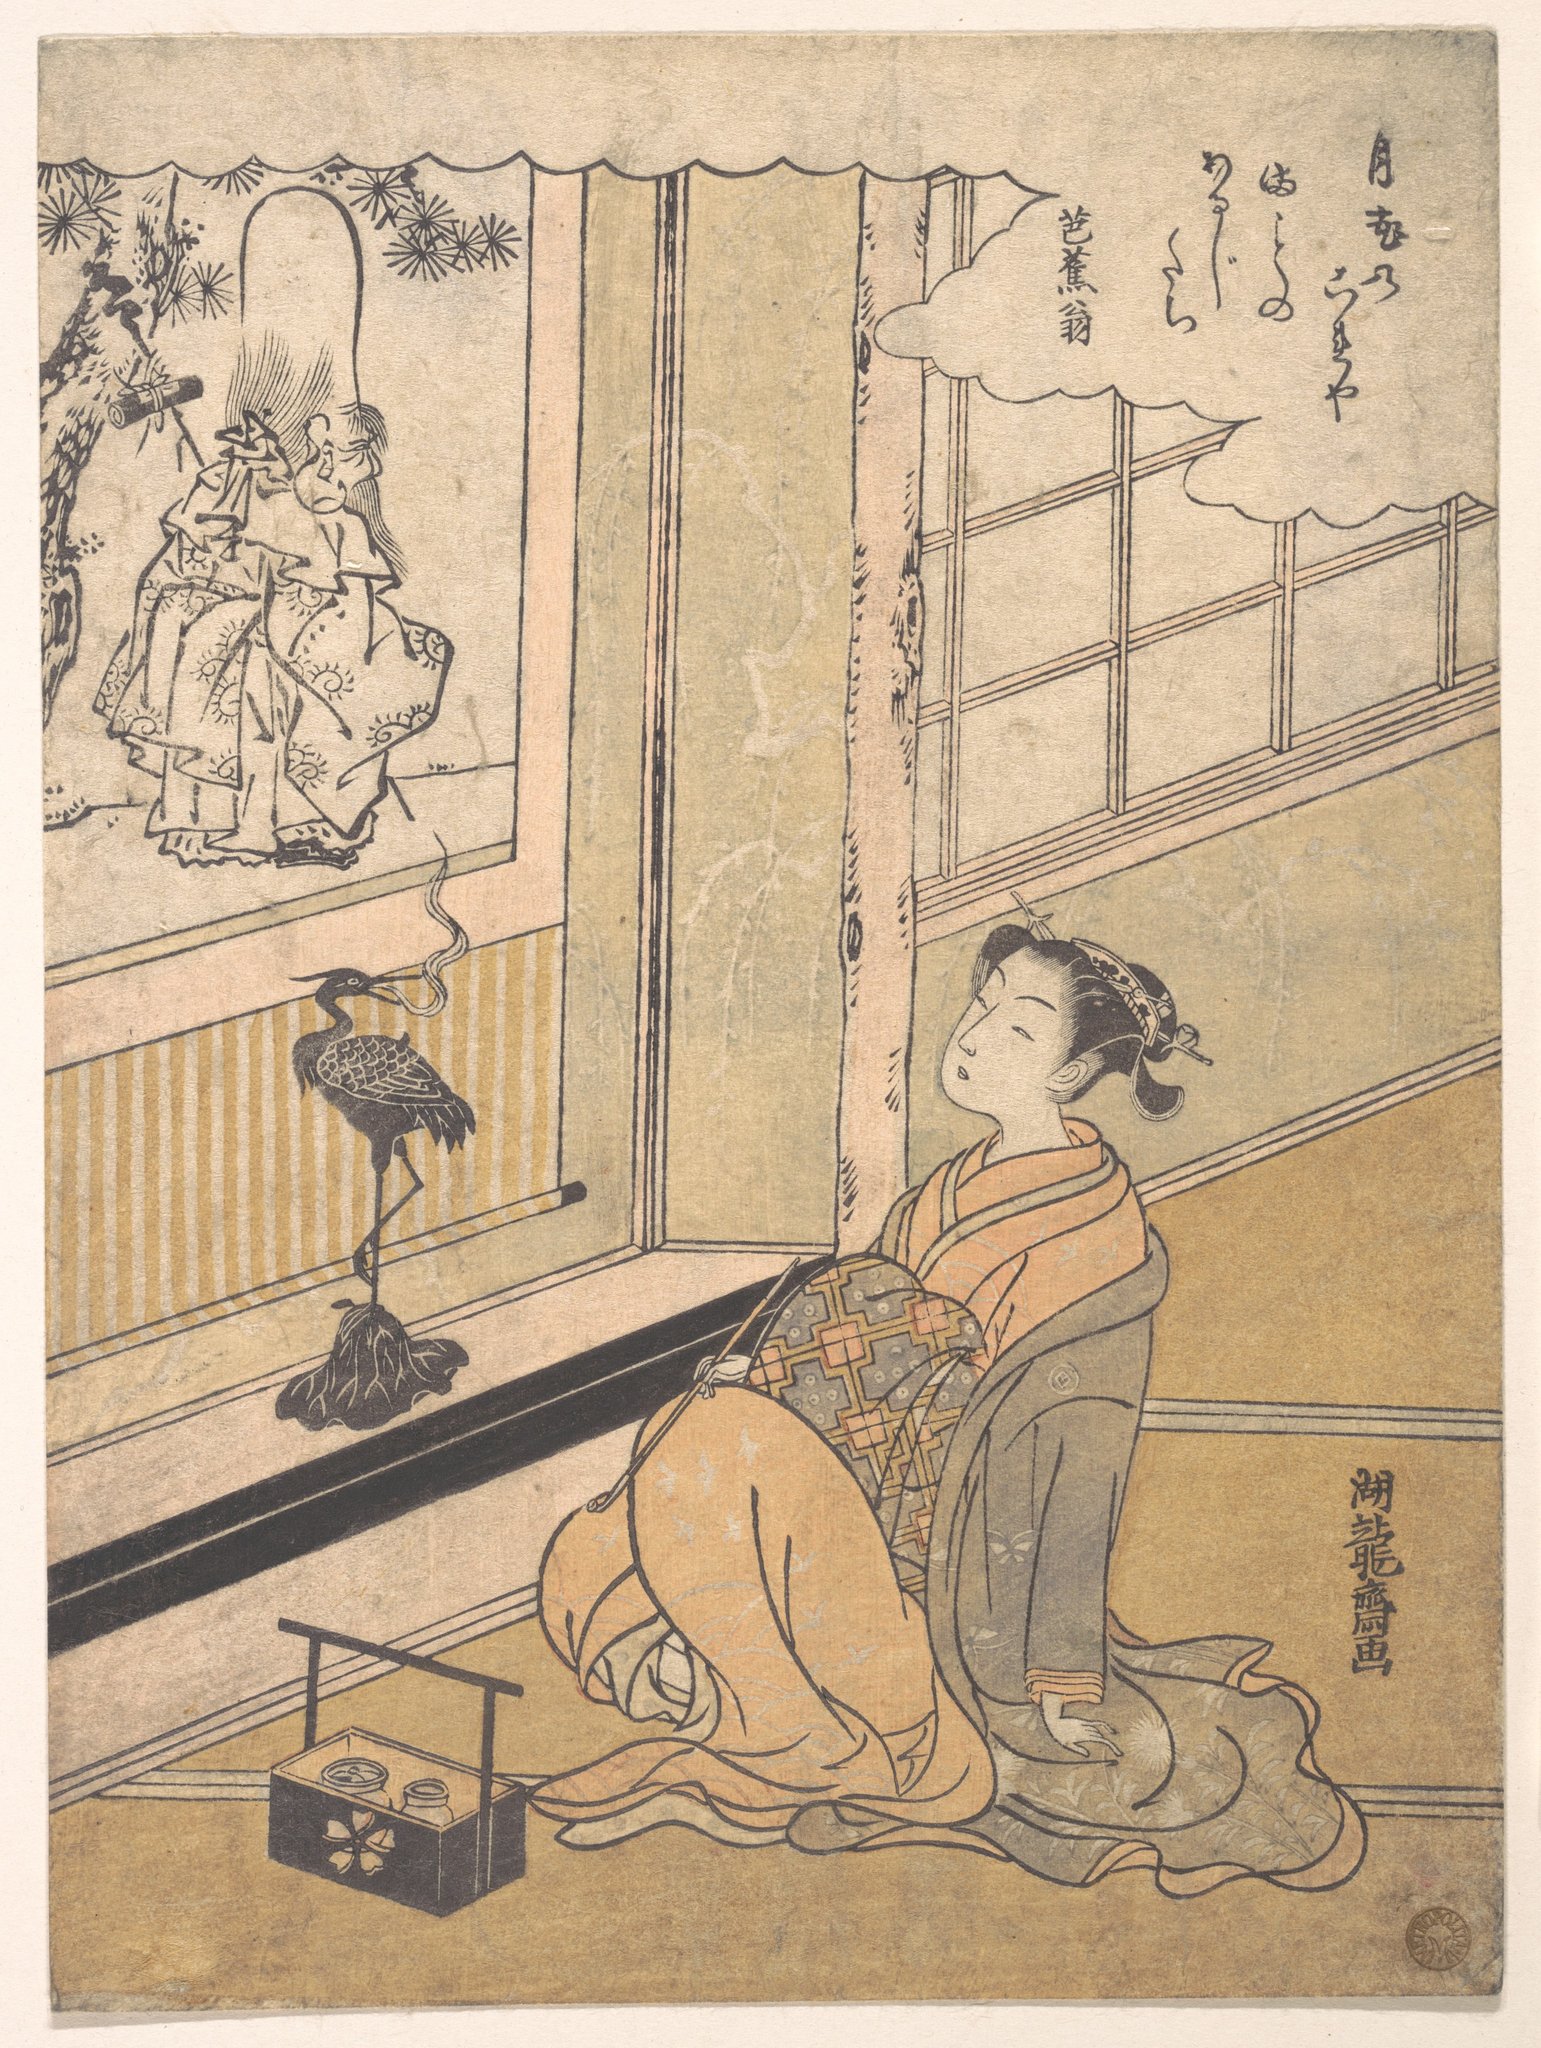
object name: print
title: A Young Woman Seated in a Room and Looking at a Kakemono of Fukurokujin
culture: japanese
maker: isoda koryūsai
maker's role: artist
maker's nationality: japanese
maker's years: 1735-1790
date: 1768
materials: ink, paper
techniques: woodblock print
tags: birds,women